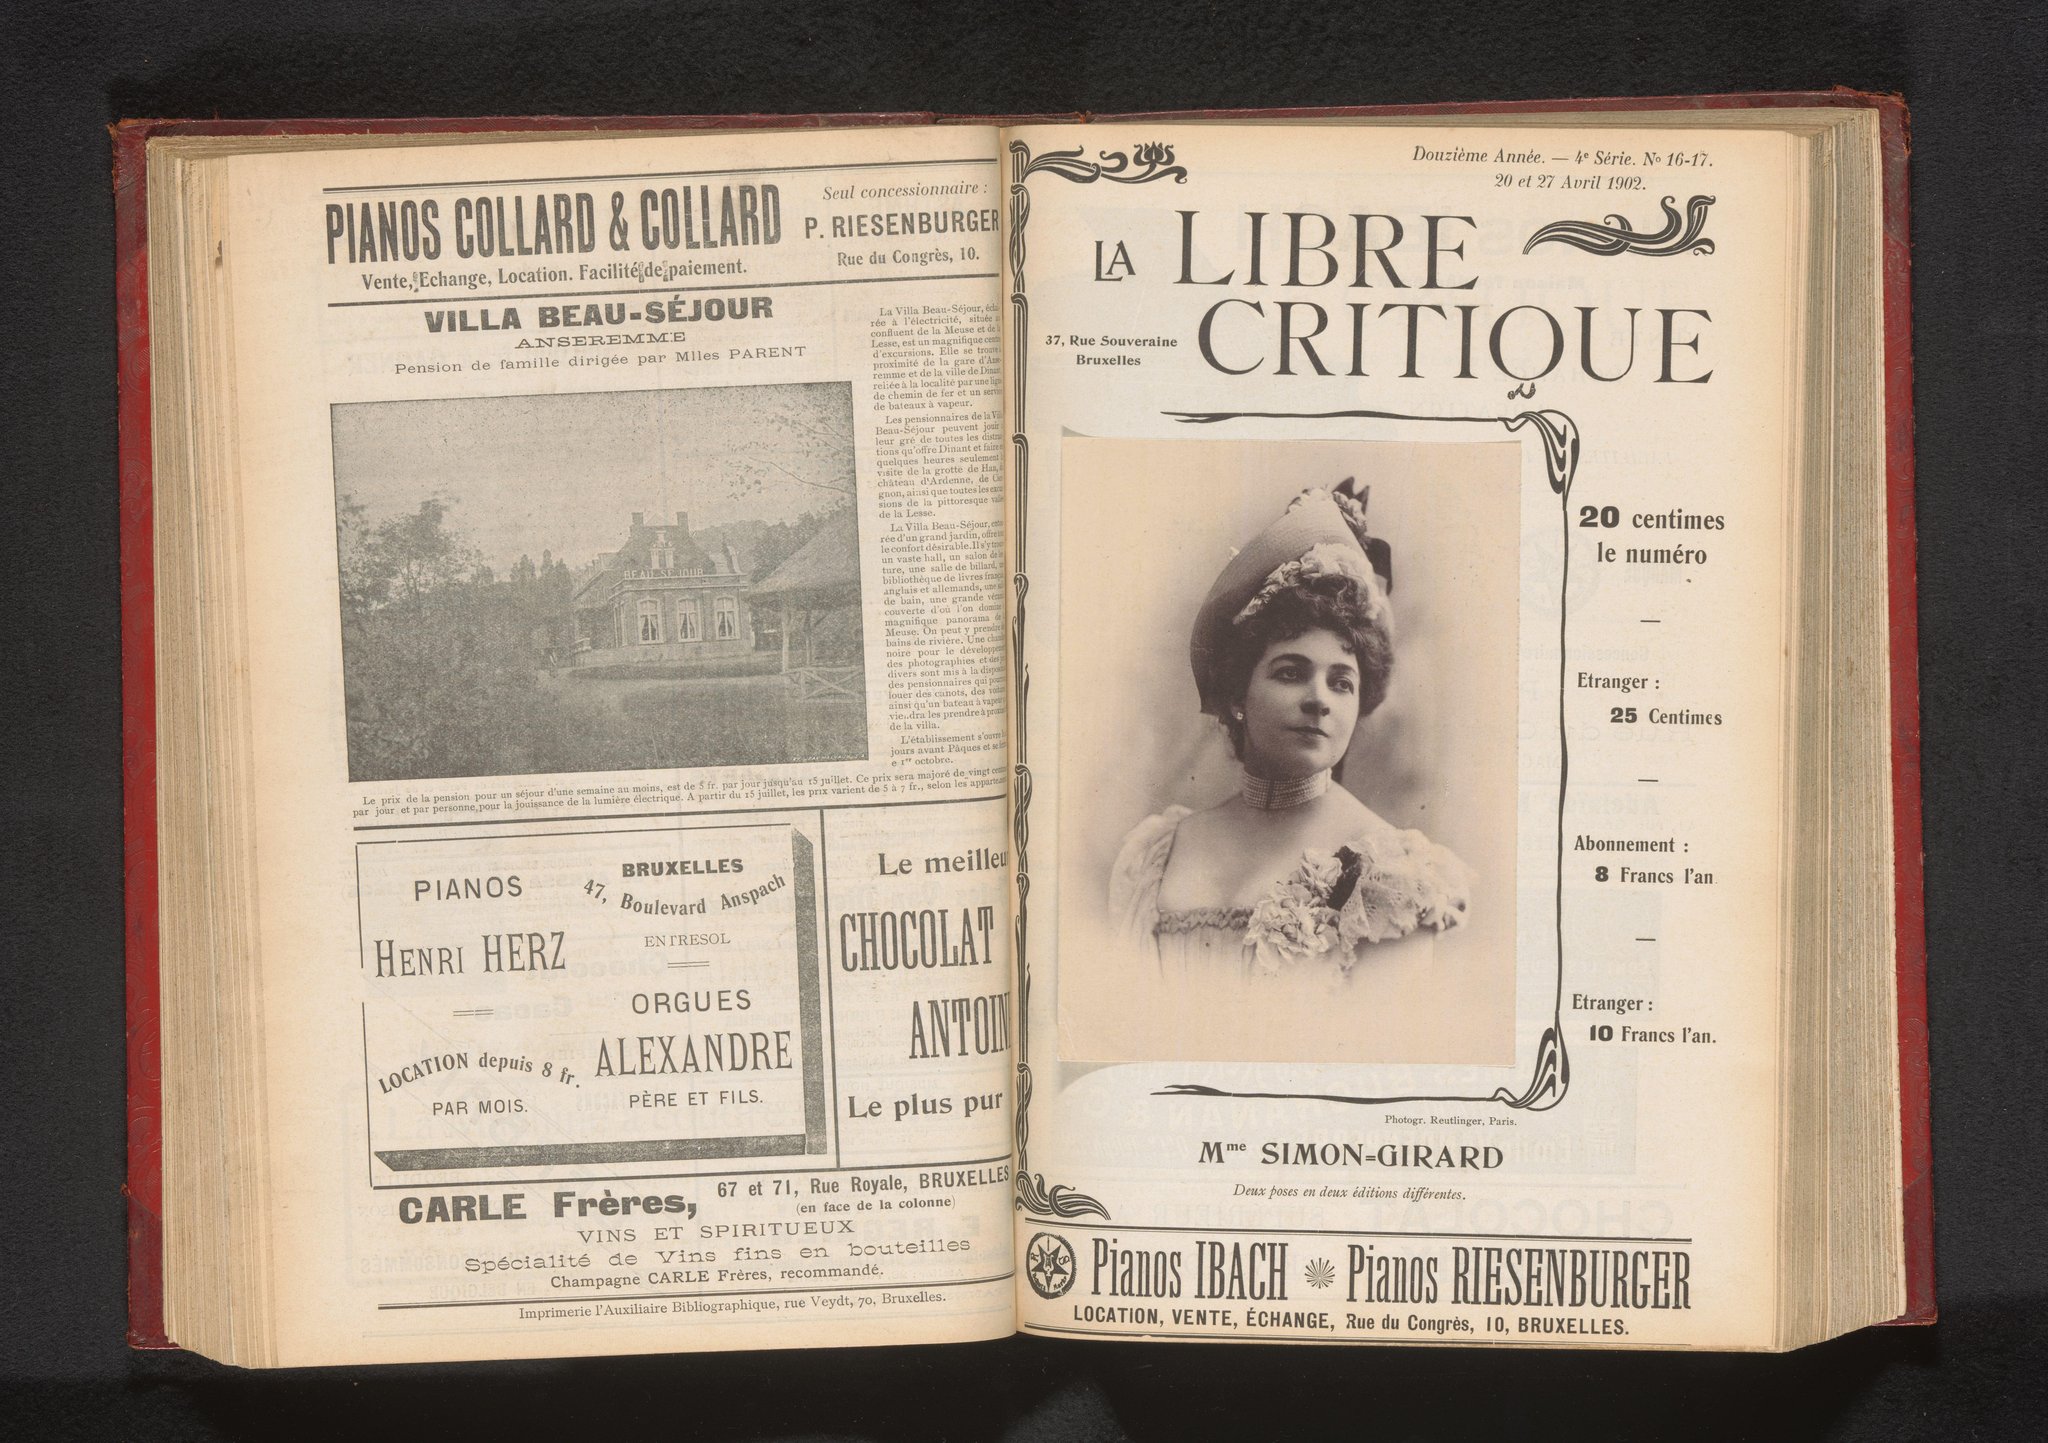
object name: page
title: Portret van Juliette Simon-Girard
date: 1897-1902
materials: paper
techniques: photograph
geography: paris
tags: paris, opera-singer (female)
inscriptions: inscription: ‘Deux poses en deux éditions différentes’